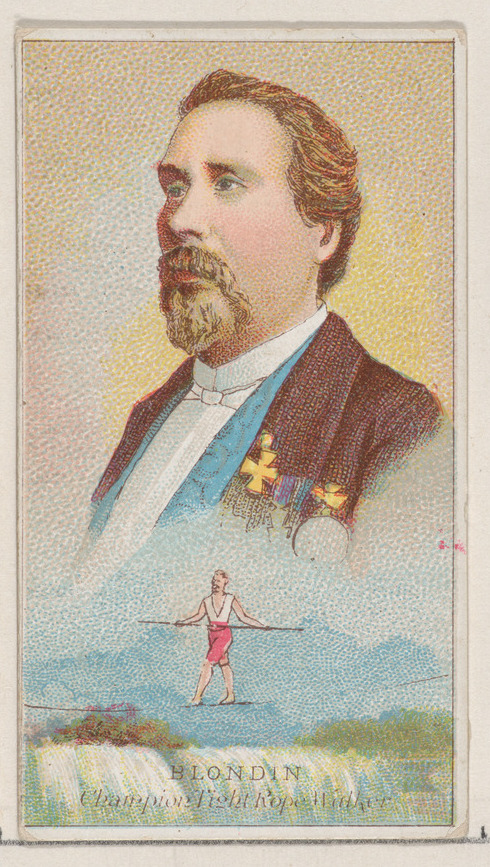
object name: print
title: Blondin, Champion Tightrope Walker, from the Champions of Games and Sports series (N184, Type 2) issued by W.S. Kimball & Co.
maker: w.s. kimball & co.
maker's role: publisher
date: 1887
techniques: color lithograph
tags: men,athletes